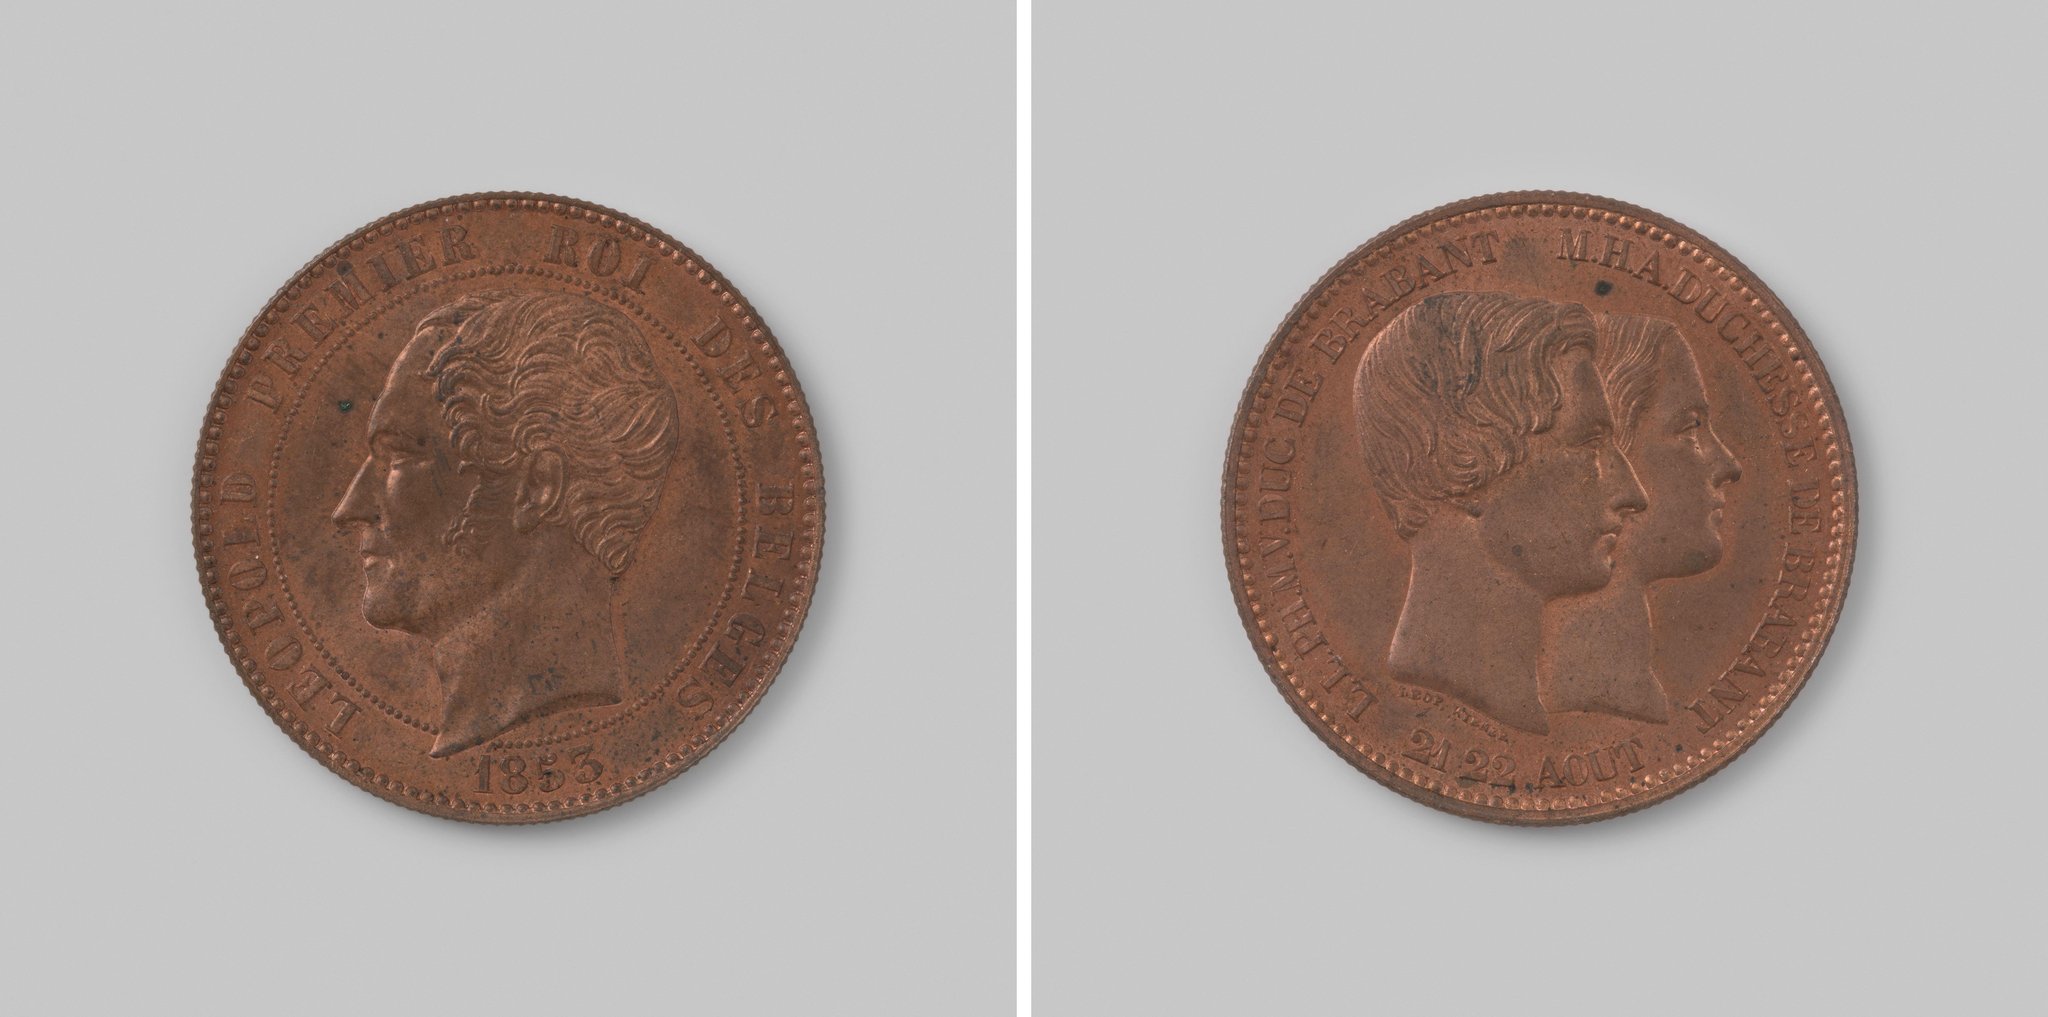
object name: history medal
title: Huwelijk van Leopold Lodewijk Filips Marie Victor, erfprins der Belgen en Henriete, prinses van Oostenrijk, ter ere van Leopold I, koning der Belgen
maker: leopold wiener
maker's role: sculptor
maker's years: 1823-1891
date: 1853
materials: bronze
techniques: striking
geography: brussels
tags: brussels, laeken, leopold ii (koning der belgen), leopold i (koning der belgen)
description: Bronzen penning. Voorzijde: borststuk man binnen omschrift. Keerzijde: borststuk man en vrouw binnen omschrift